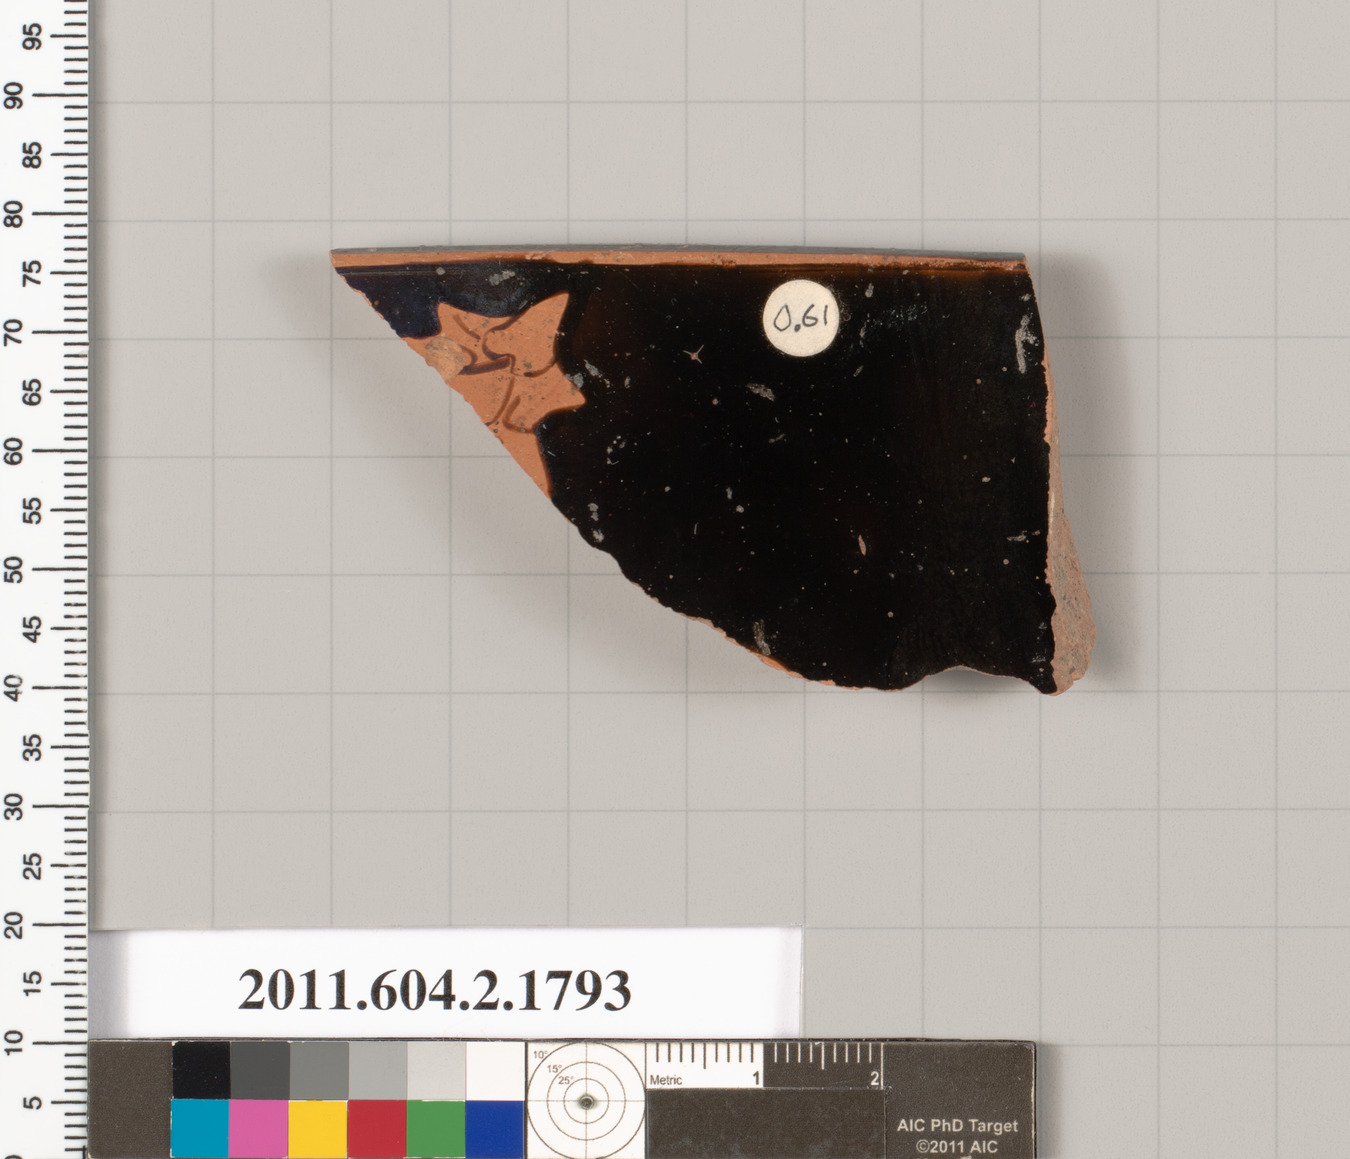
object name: skyphos fragment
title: Terracotta rim fragment of a skyphos (deep drinking cup)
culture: greek, attic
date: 460-440 BCE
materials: terracotta